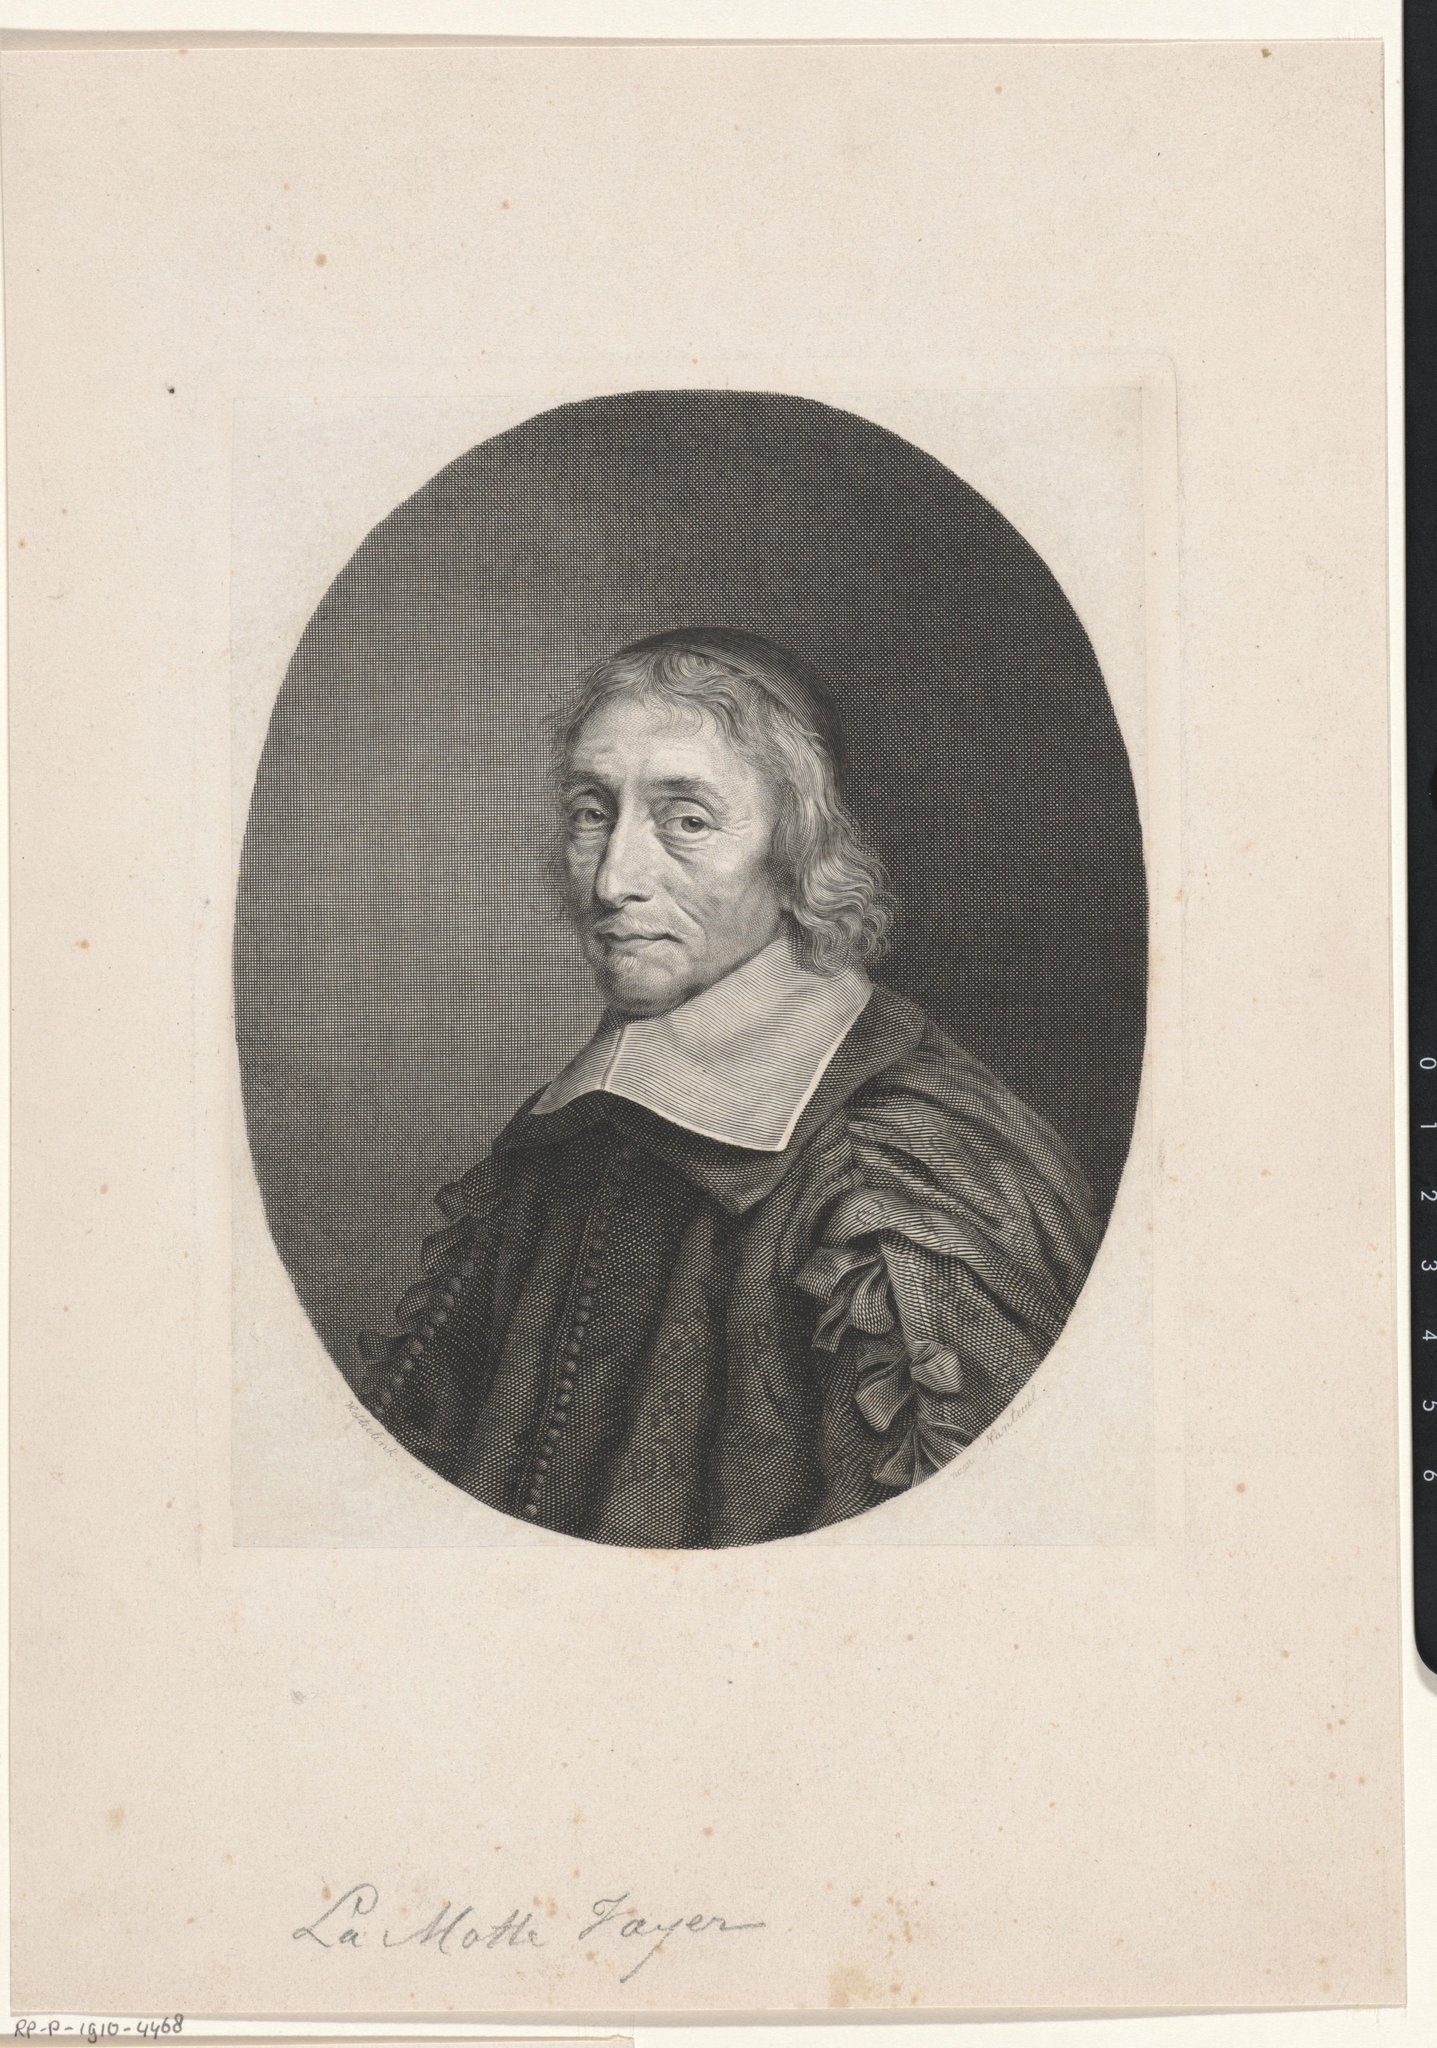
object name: print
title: Portret van François de La Mothe Le Vayer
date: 1846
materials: paper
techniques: engraving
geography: amsterdam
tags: paris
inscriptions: collector's mark: Lugt 2228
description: Portret van Frans schrijver François de La Mothe Le Vayer.